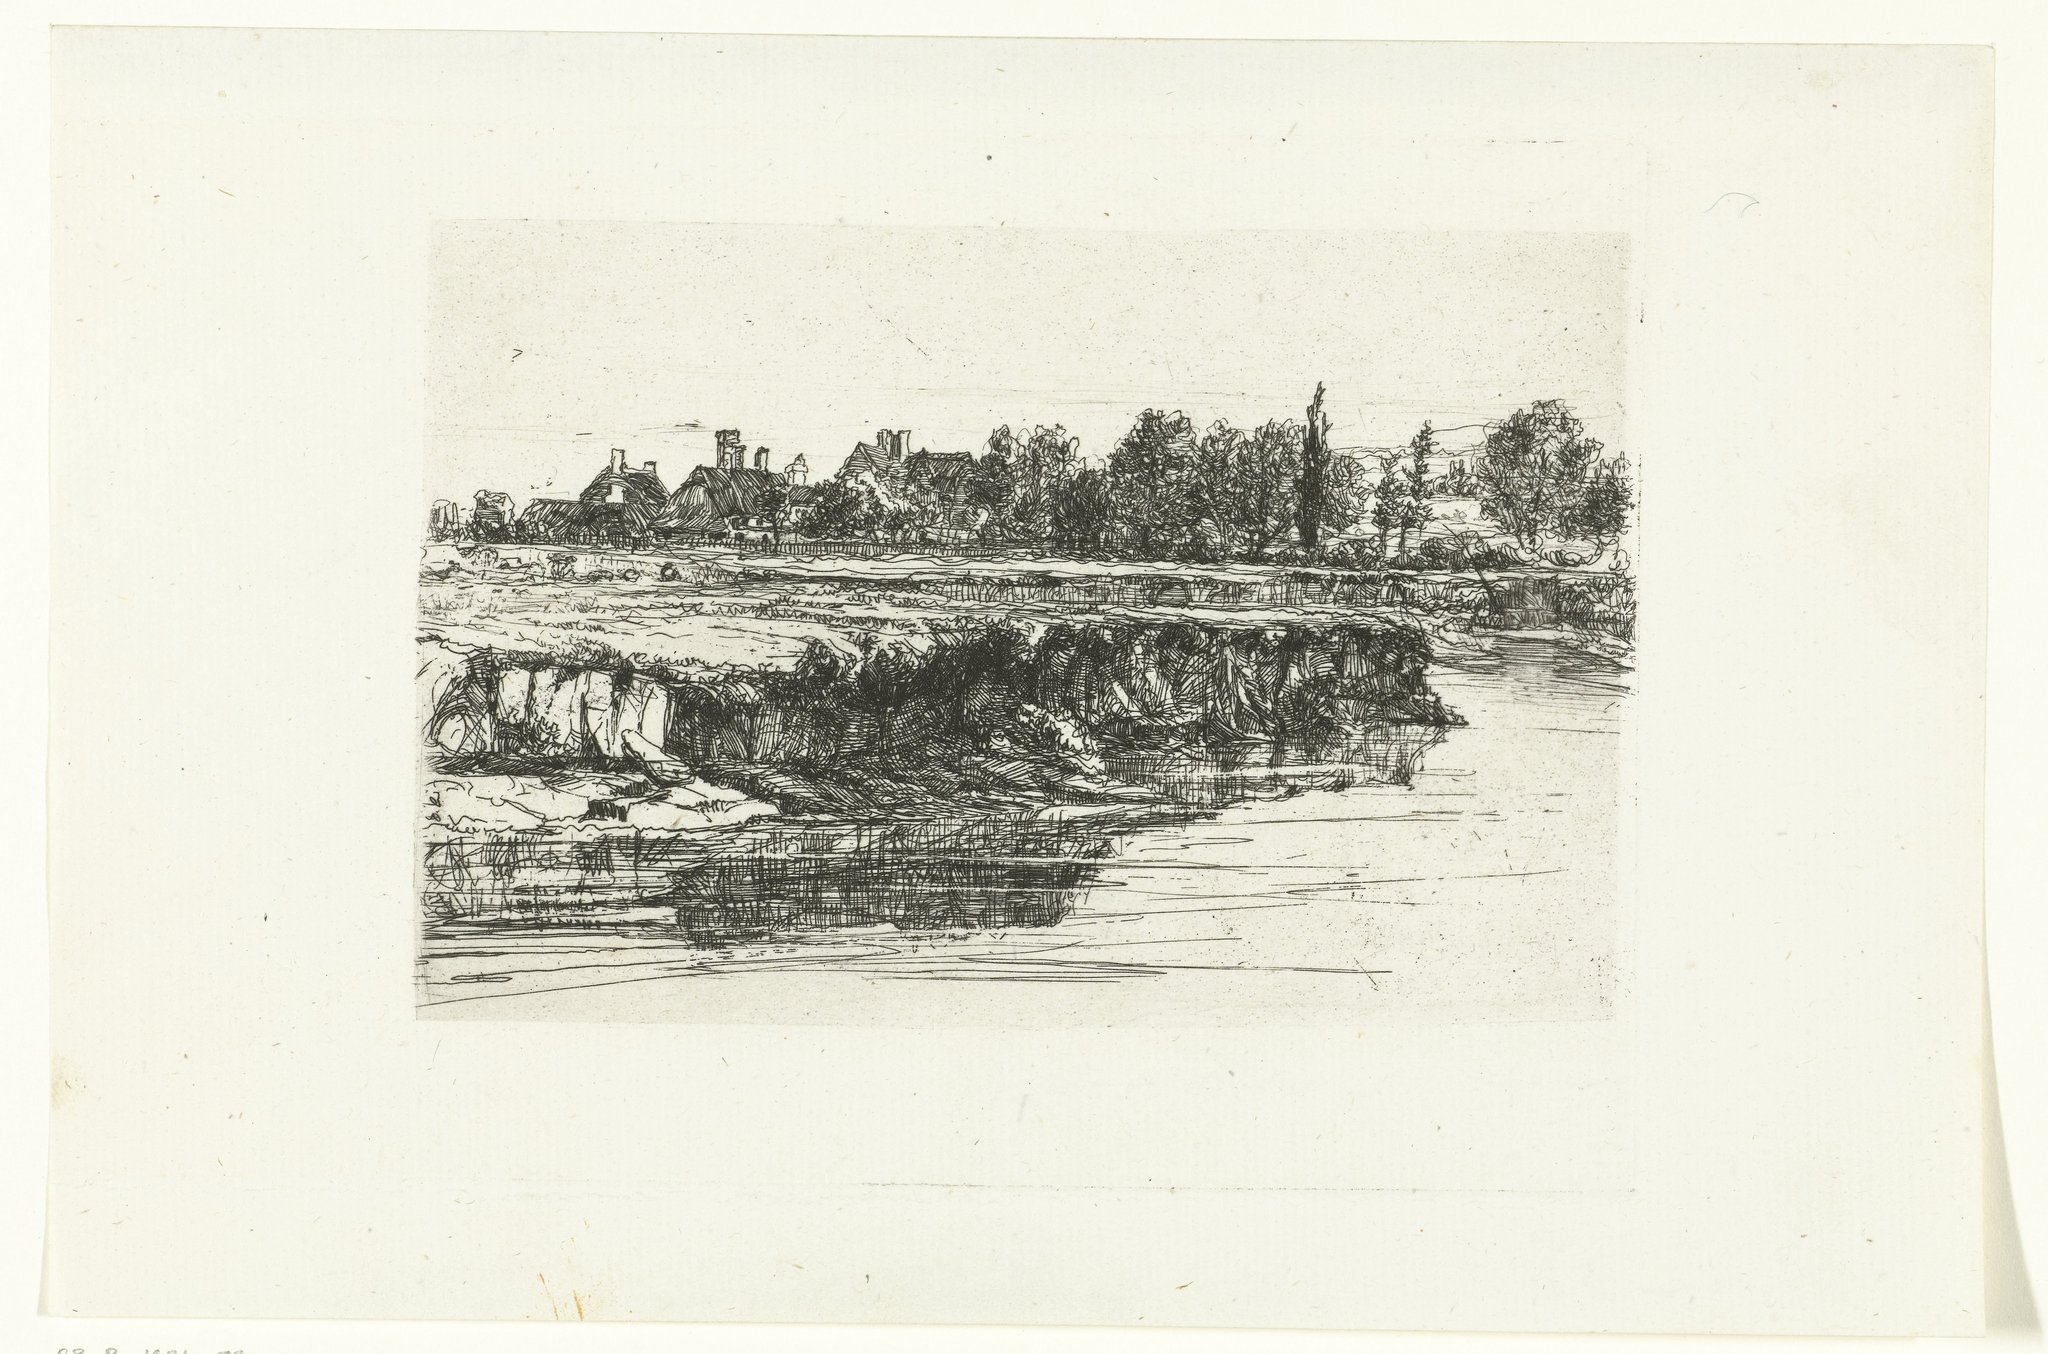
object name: print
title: Oever van de Theems bij Sonning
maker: francis seymour-haden (sir)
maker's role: print maker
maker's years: 1818-1910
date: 1863-1868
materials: paper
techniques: drypoint, etching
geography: england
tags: river bank, thames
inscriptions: collector's mark: Lugt 2228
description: Oever van de Theems met in de verte een aantal huizen.